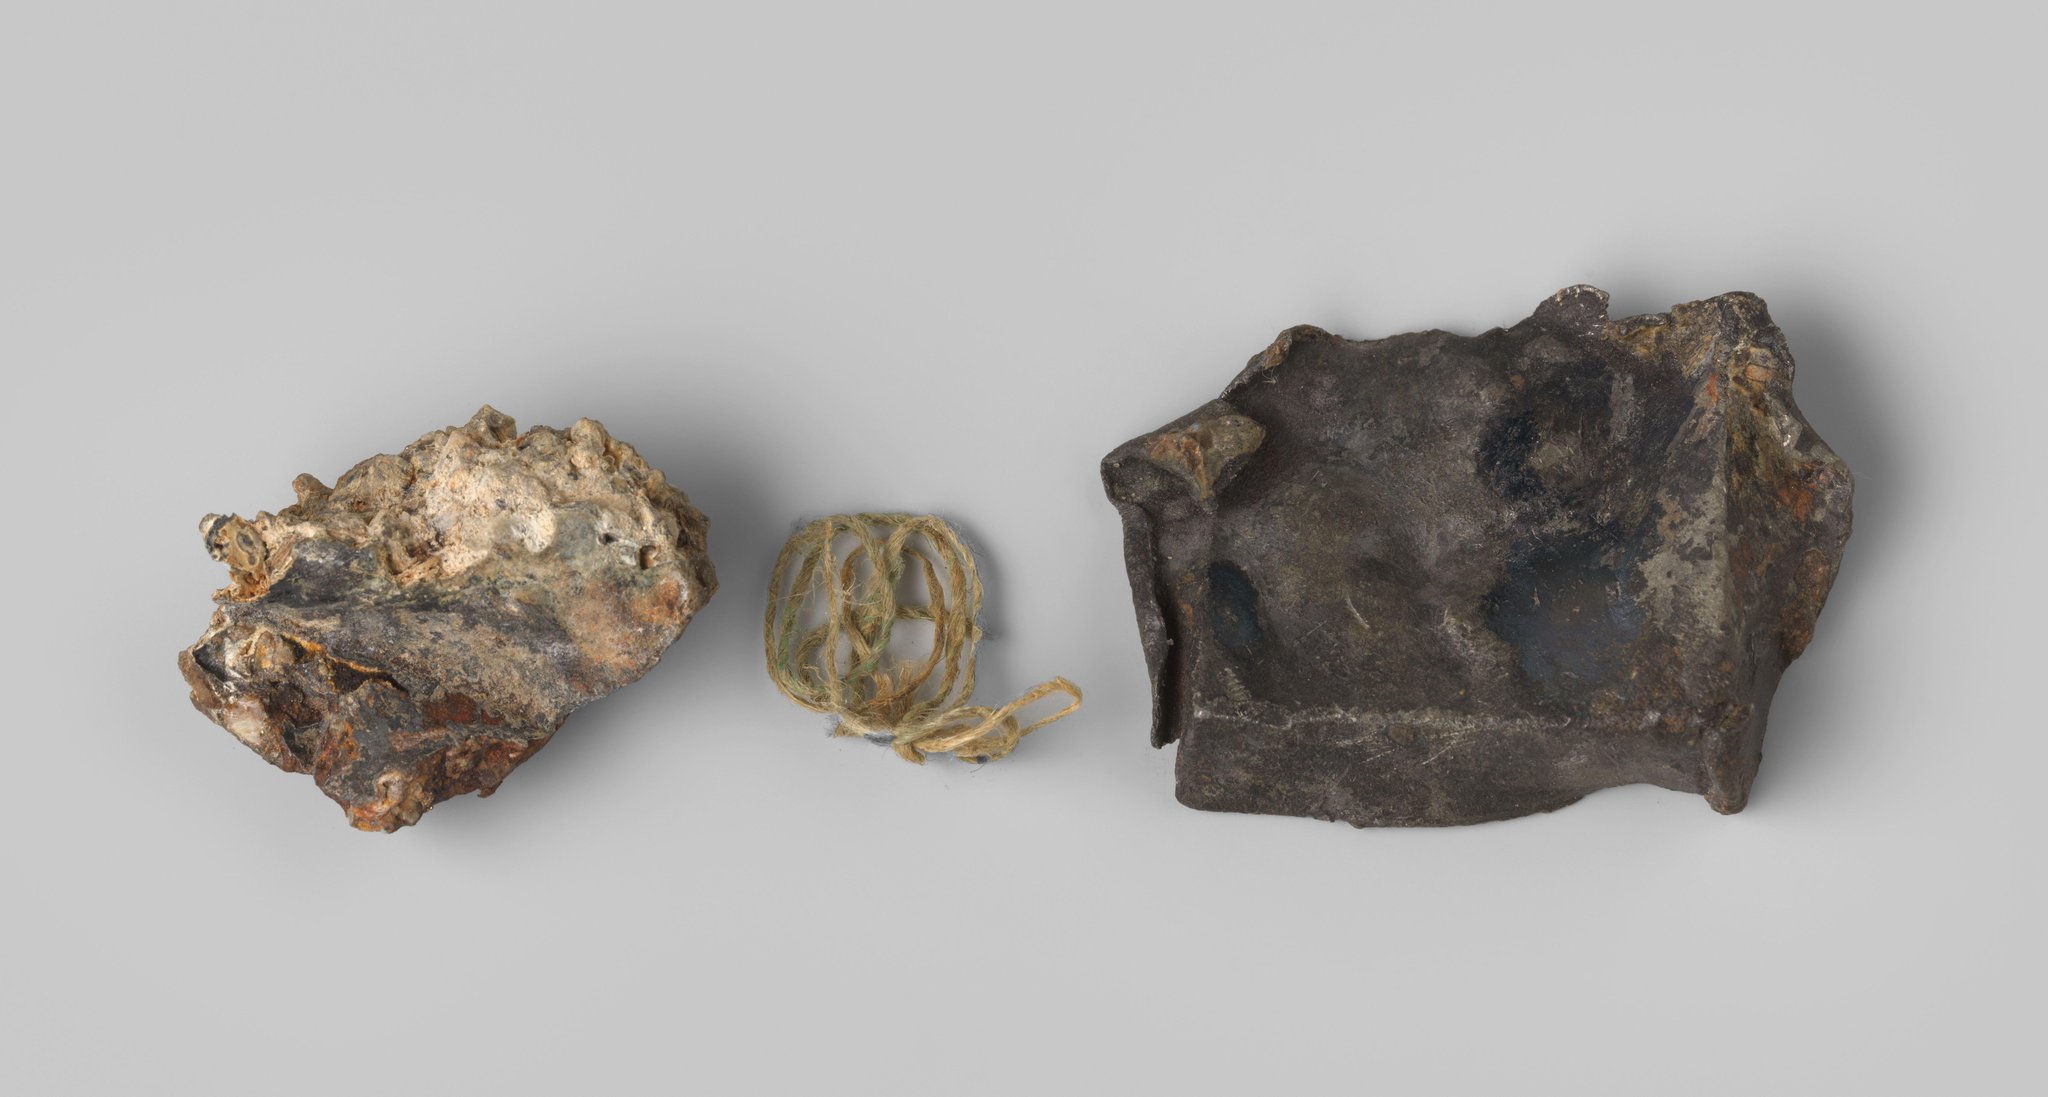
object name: lid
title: Deksel van een verpakking, brok concretie en touw uit het wrak van de Oost-Indiëvaarder Hollandia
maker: Anonymous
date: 1700-1743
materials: stone, fiber, tin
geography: netherlands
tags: verenigde oostindische compagnie, hollandia (schip), annet